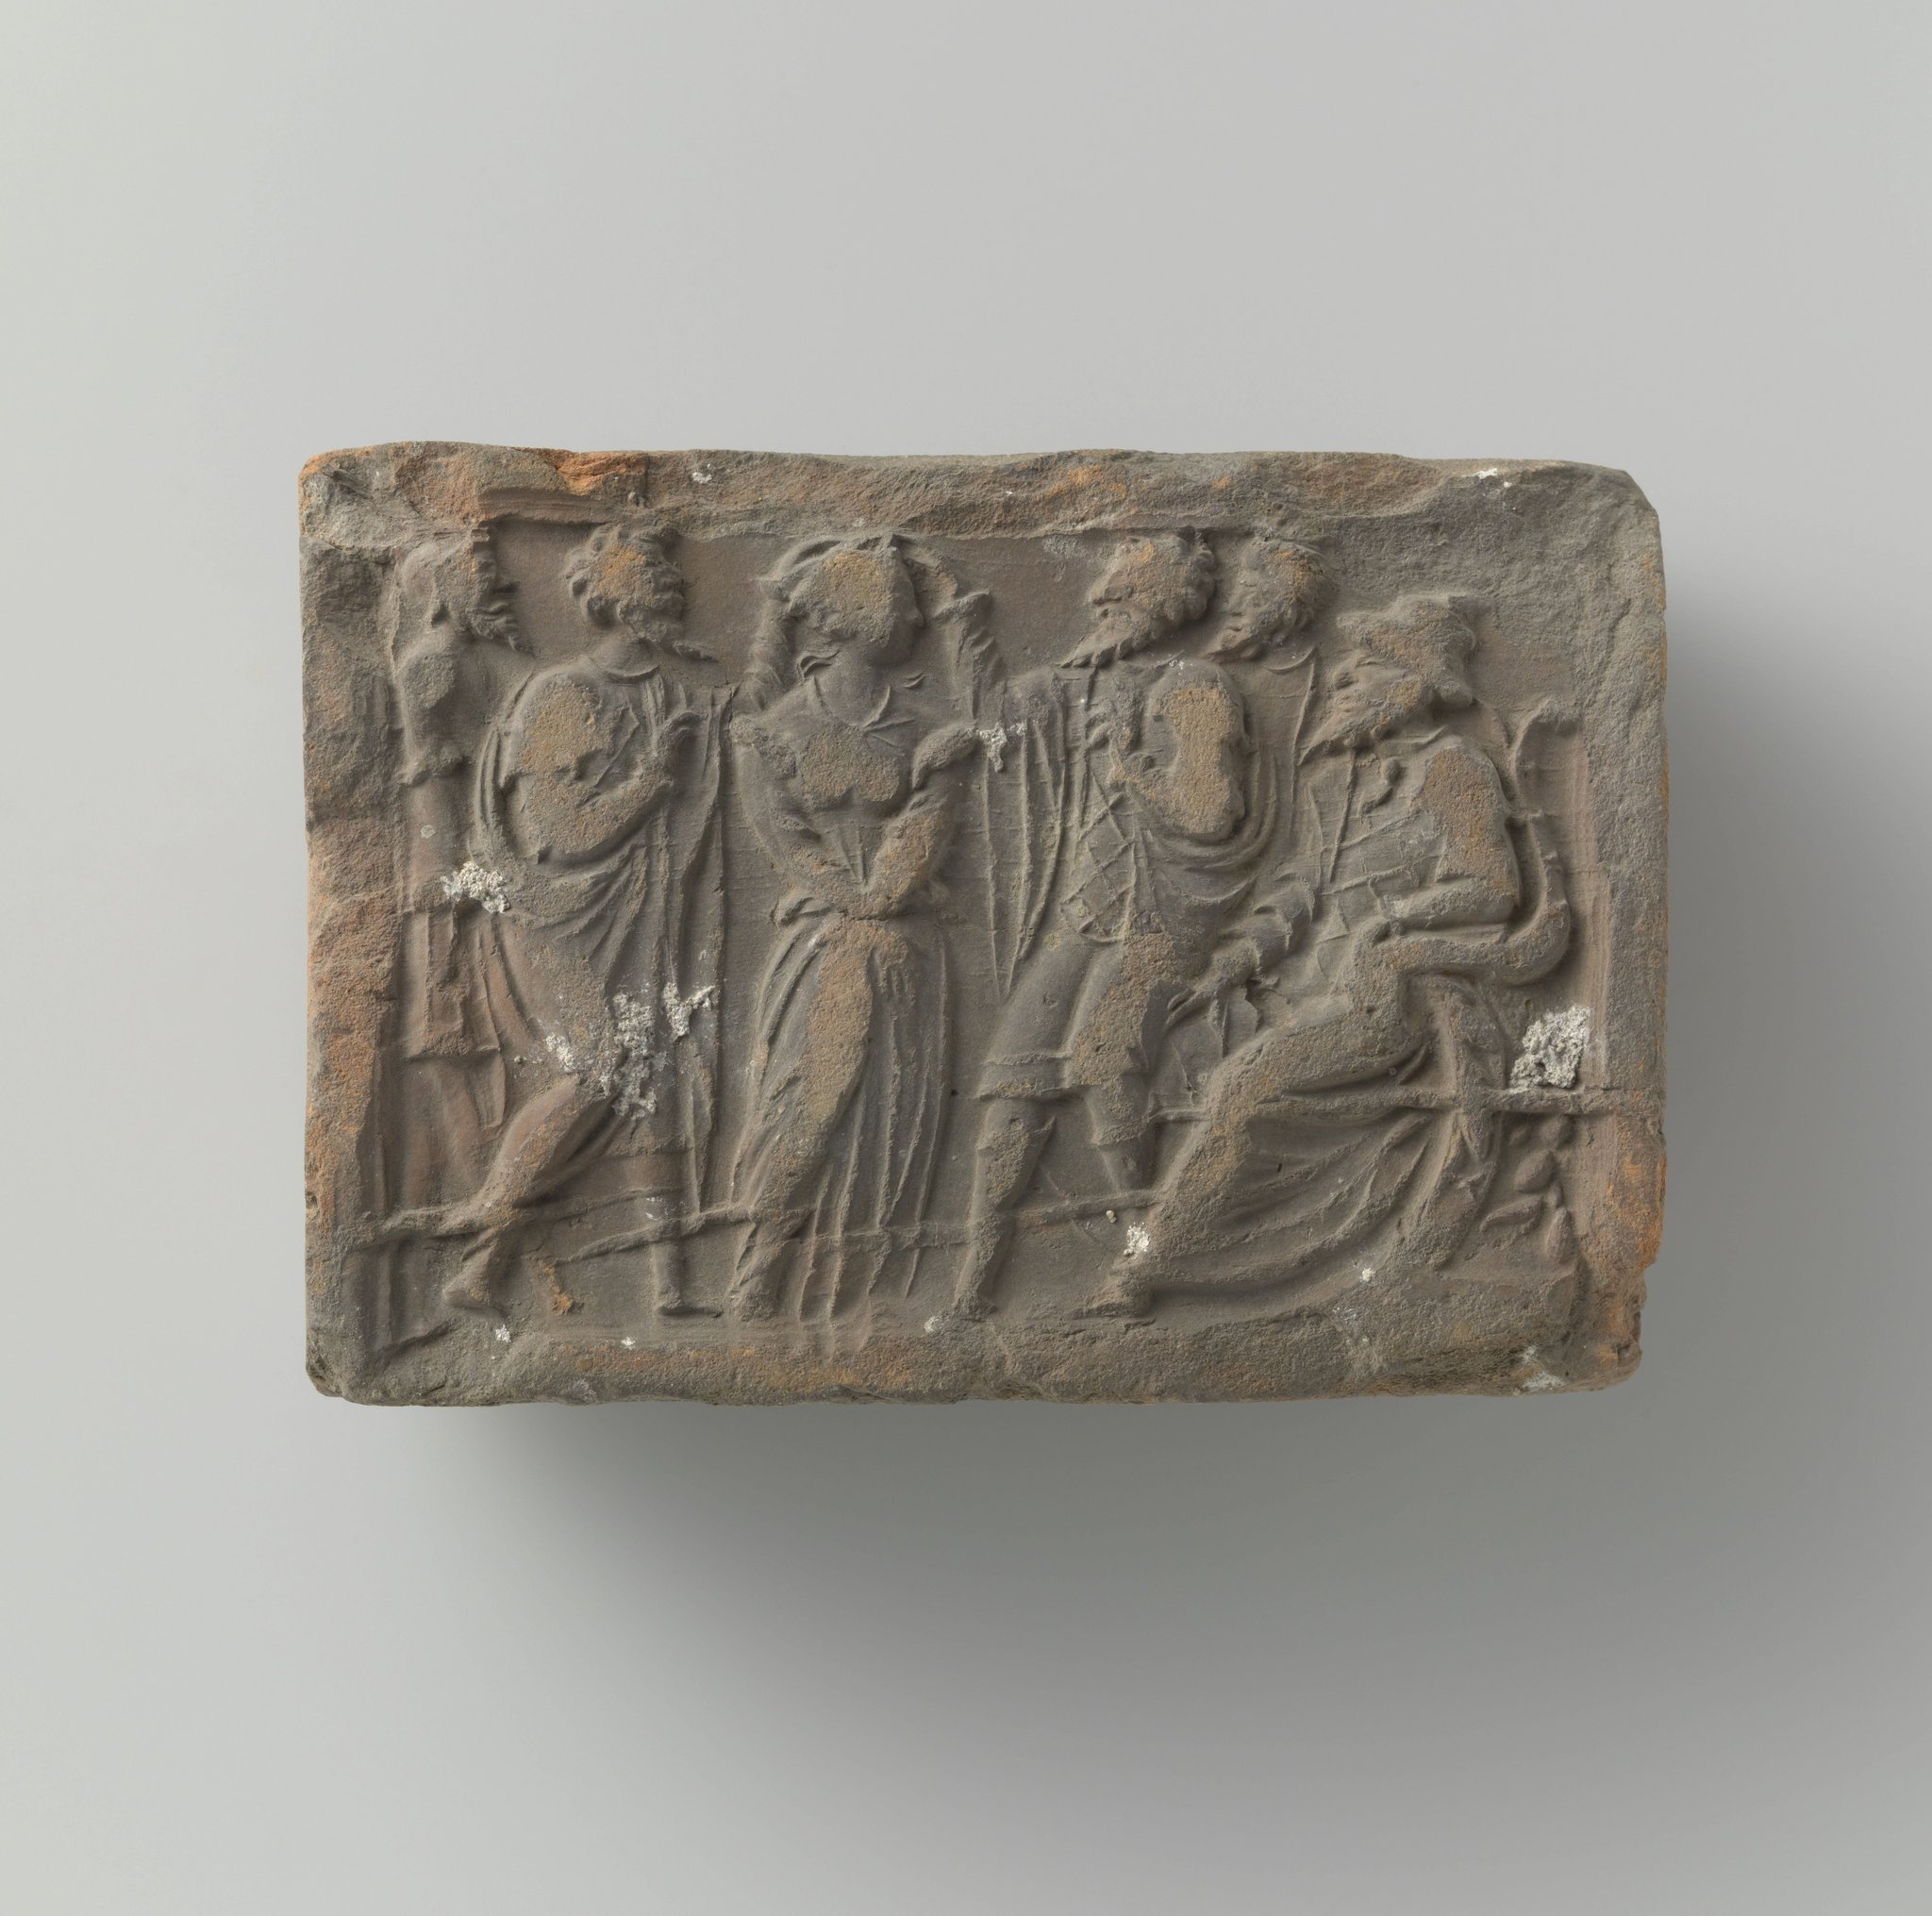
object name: hearthstone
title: Haardsteen met voorstelling van Suzanna, die door de twee ouderlingen voor de rechter wordt gevoerd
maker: Anonymous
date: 1550-1600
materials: earthenware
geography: southern netherlands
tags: the elders accusing susanna before the people, laying their hands on her head or unveiling her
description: Haardsteen met voorstelling van Suzanna, die door de twee ouderlingen voor de rechter wordt gevoerd.